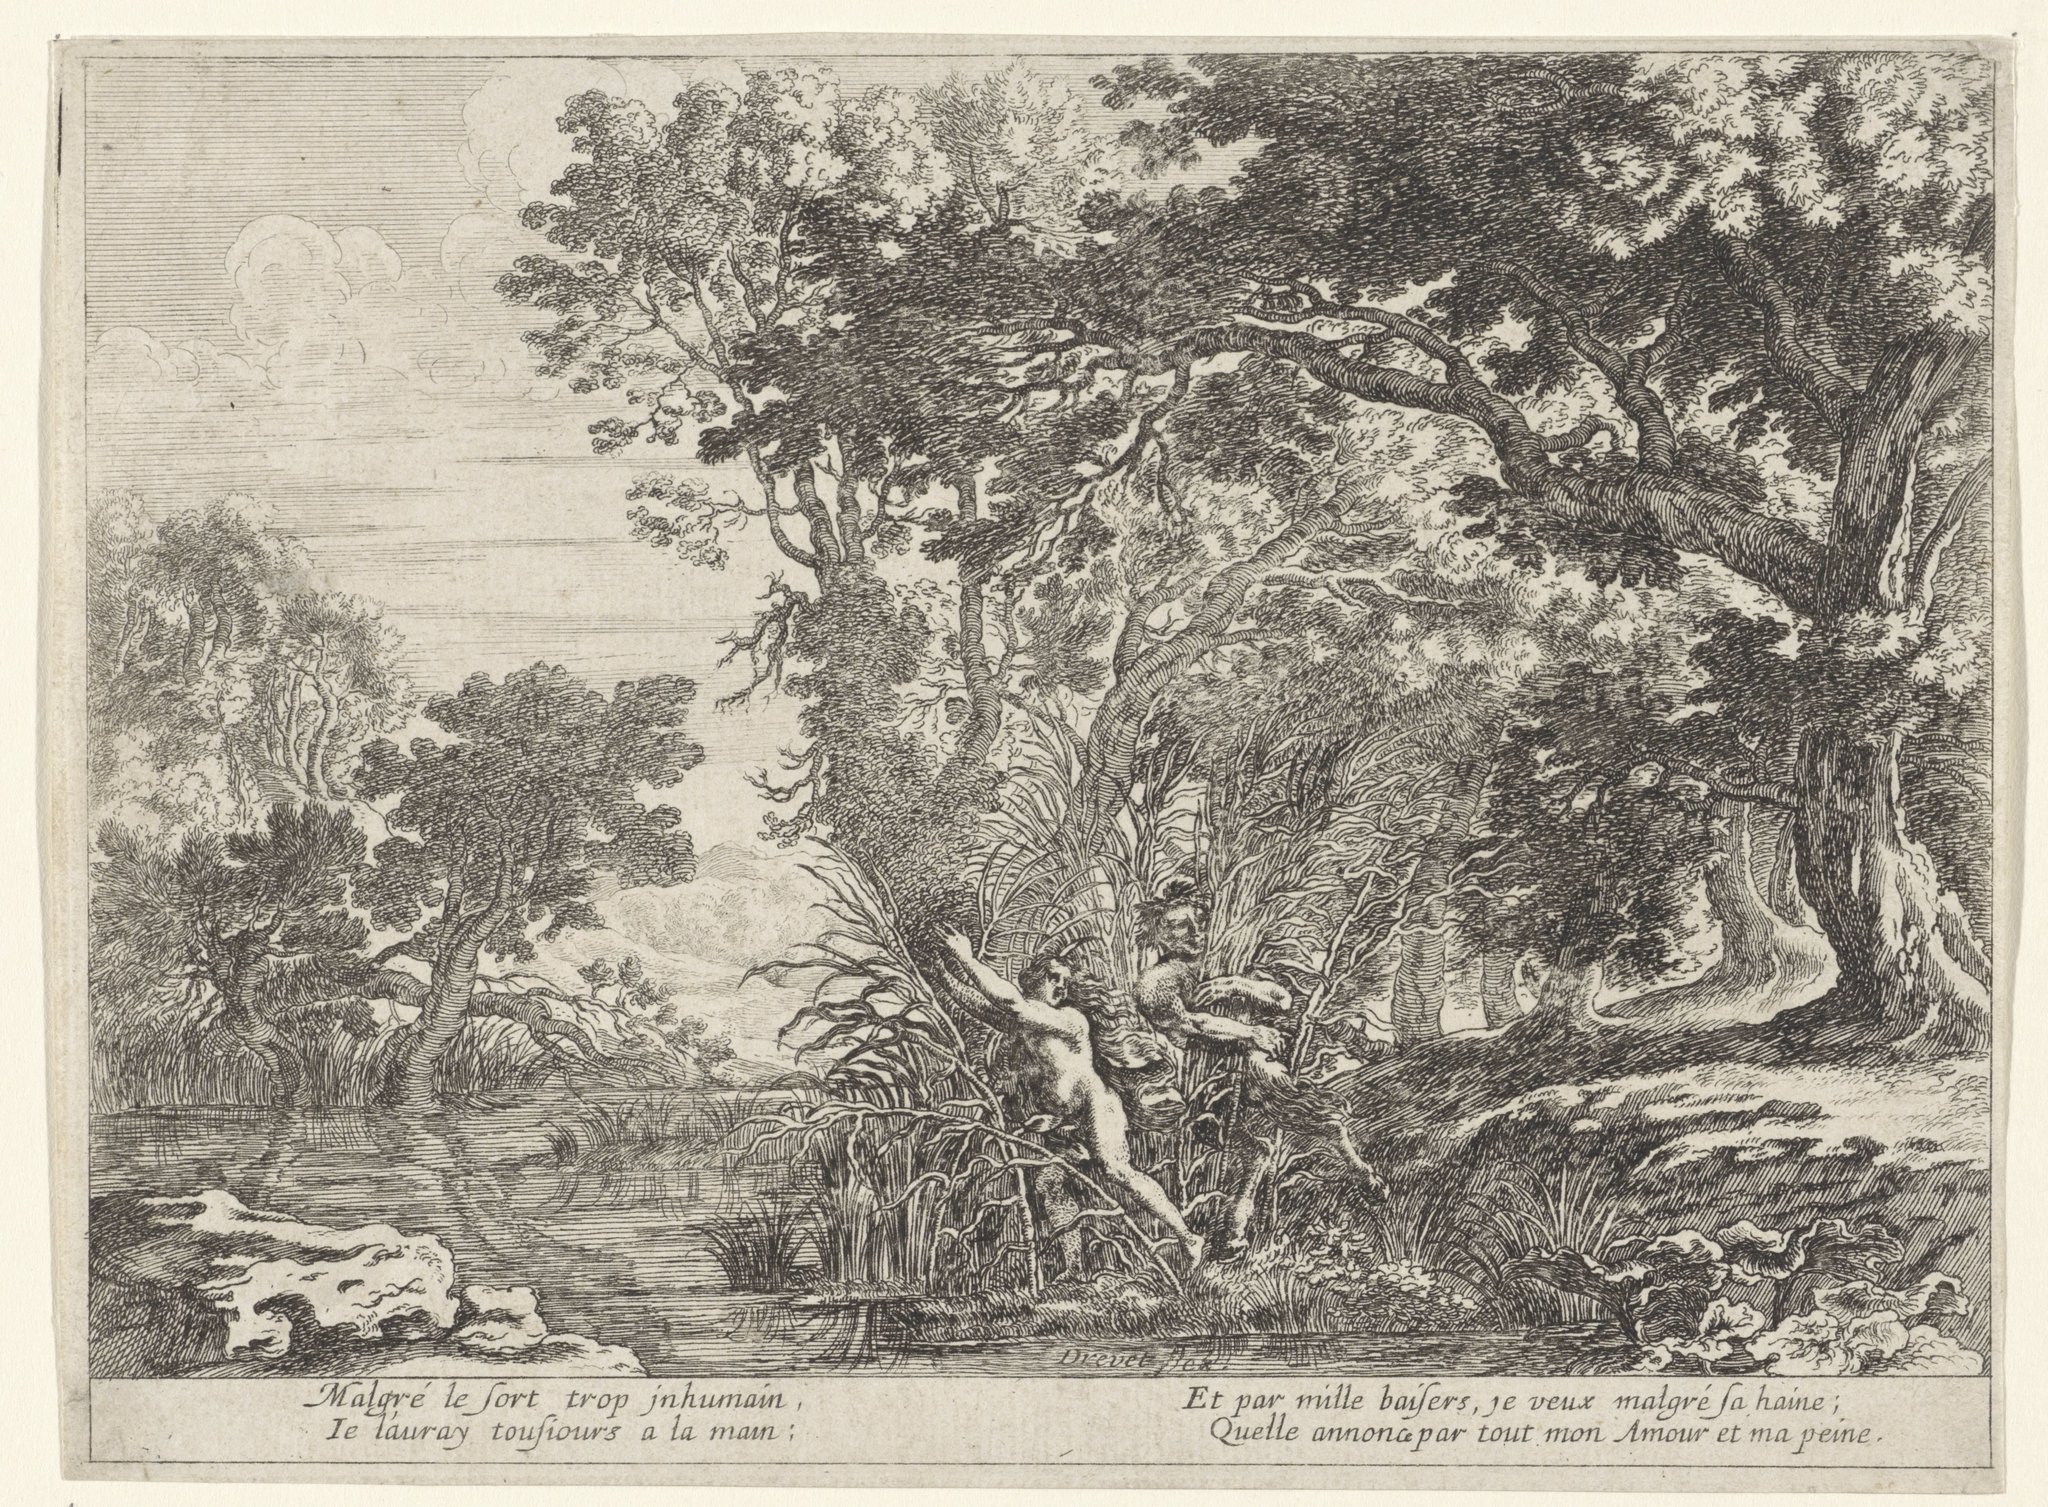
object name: print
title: Pan en Syrinx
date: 1663-1738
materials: paper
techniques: etching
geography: paris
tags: syrinx changed into a reed: while fleeing from pan, the nymph syrinx is changed into reed by her sisters, the naiads (ovid, metamorphoses i 705)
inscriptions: collector's mark: Lugt 2228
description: Pan omarmt een bos riethalmen, de nimf Syrinx, terwijl een nimf in het riet voor hem wegvlucht in de richting van de rivier. Onder de voorstelling bevindt zich een vierregelig, Frans gedicht.